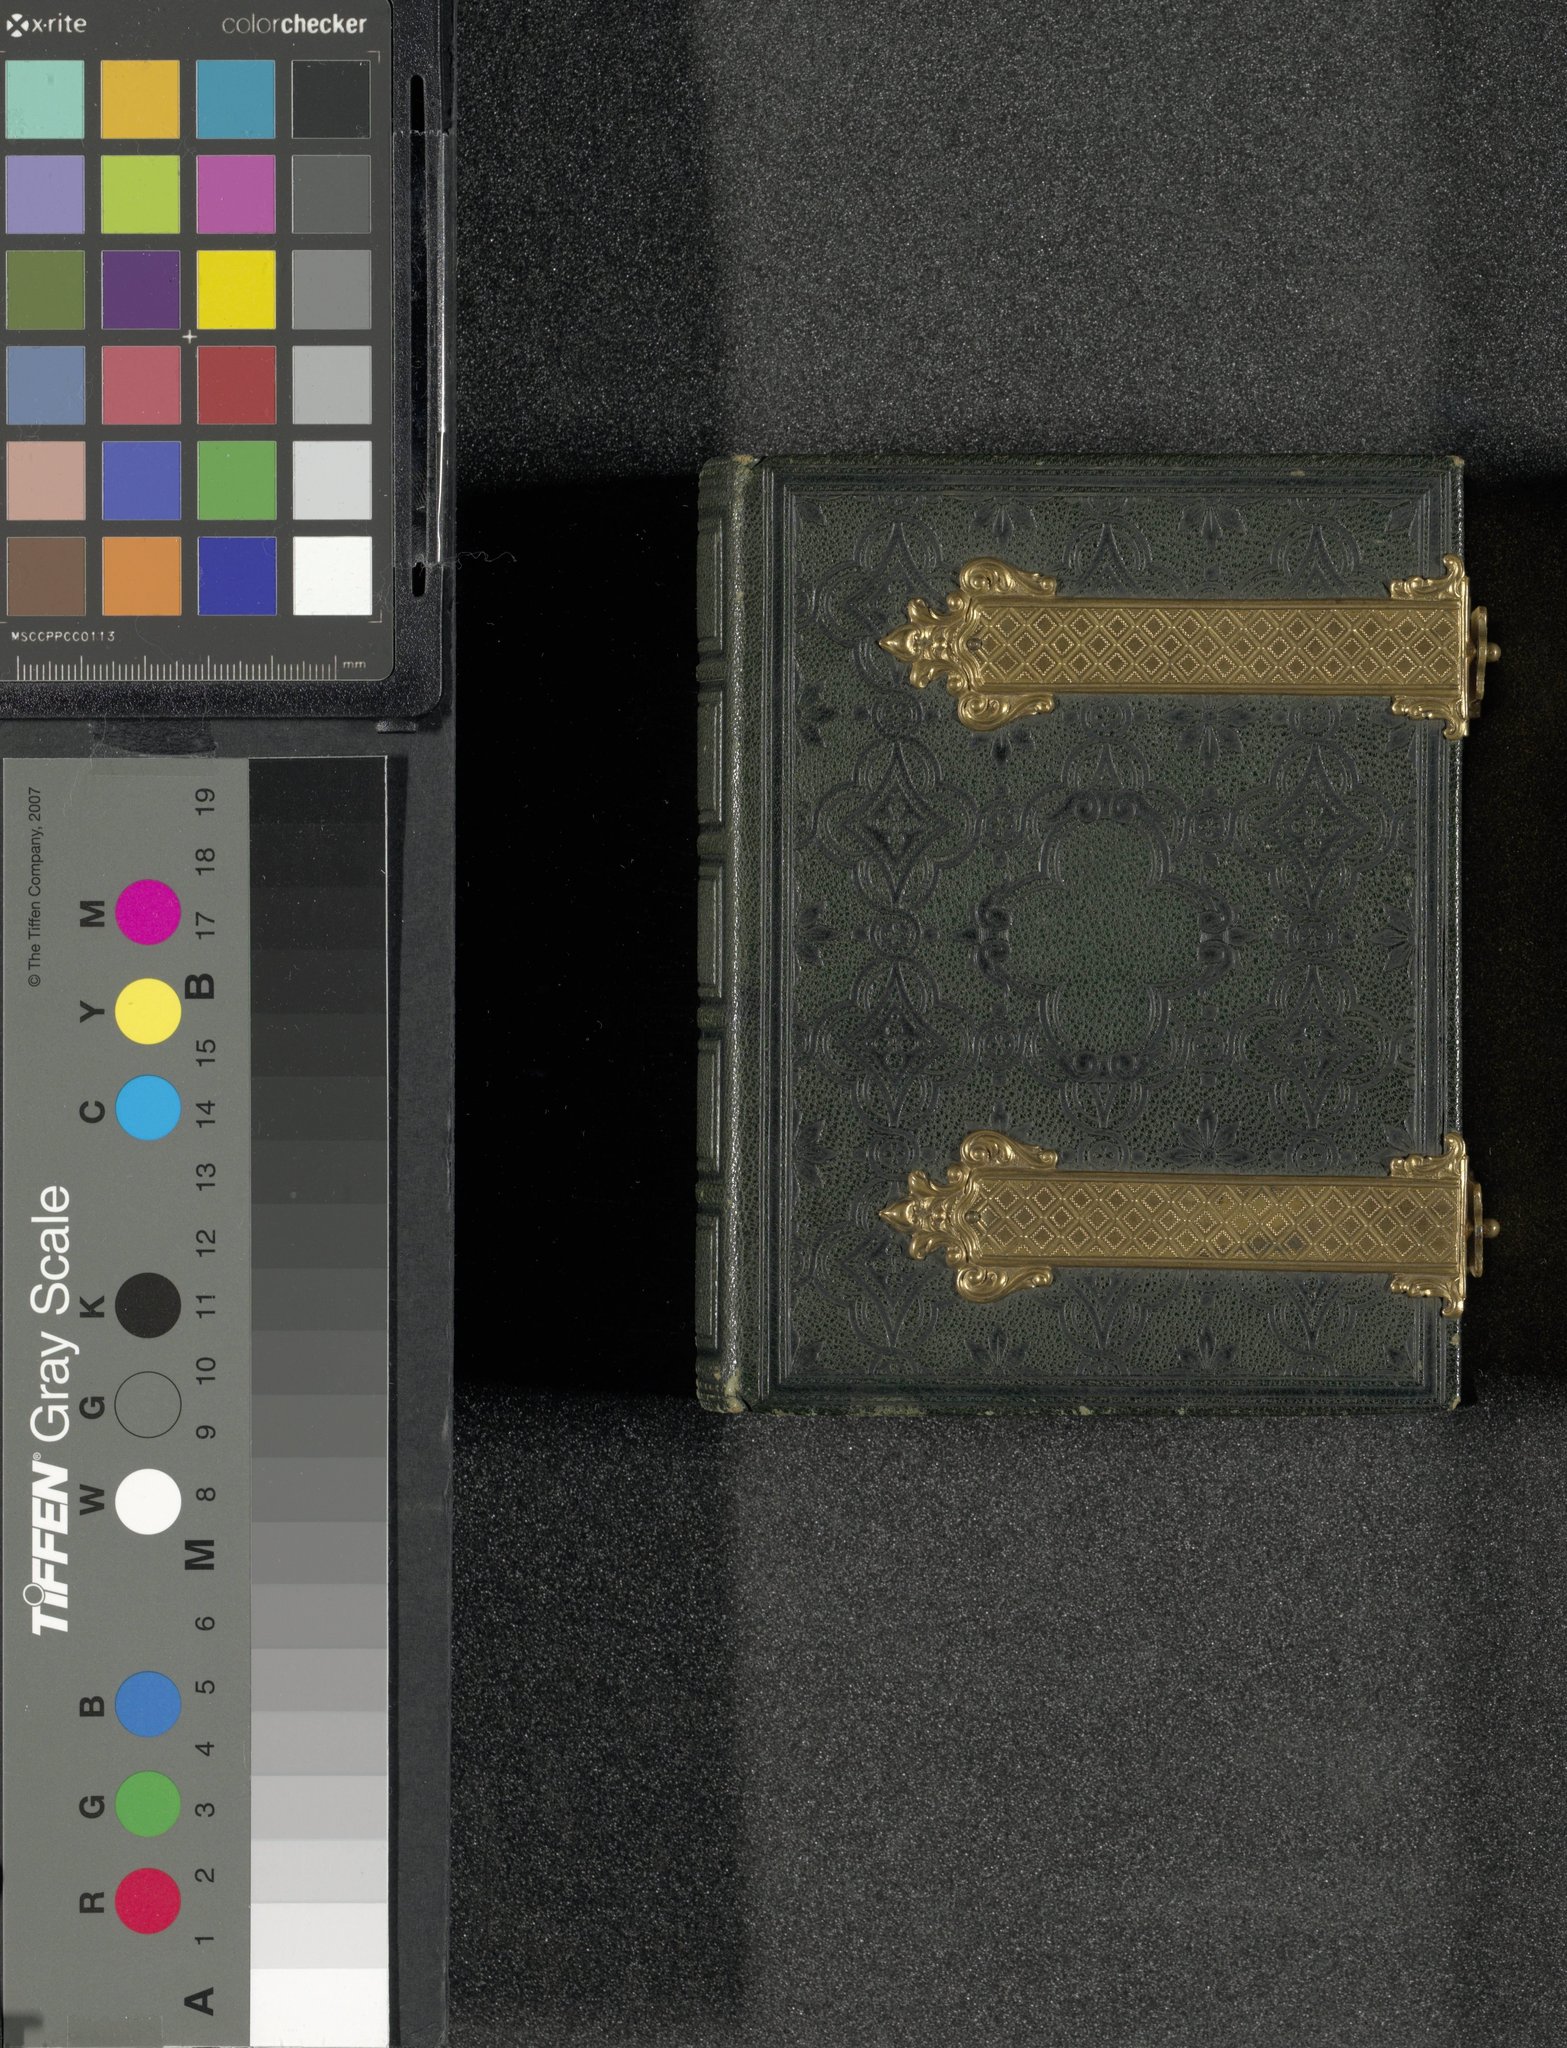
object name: photograph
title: Fotoalbum met 29 foto's van Nederlandse vorsten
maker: Anonymous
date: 1860-1890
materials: brass, cardboard, leather, paper, photographic support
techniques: albumen print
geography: europe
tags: historical persons, ruler, sovereign - bb - female ruler, ruler, sovereign, stadtholder, netherlands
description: Fotoalbum in groen omslag met geometrische en plantenmotieven in reliëf. De voor-en achterzijde zijn voorzien van koperkleurig versierd beslag. Aan de zijkant twee sloten. De schutbladen zijn van changeantpapier. Het album bevat 15 insteekbladen met goud op snee. Daarin 29 foto's op het formaat van cartes-de-visite in passe-partouts. Elk passe-partout heeft een kader in gouddruk. Het betreft opnames, vaak naar een prent, van leden van het Nederlandse vorstenhuis. In een hoesje is bijgevoegd een handgeschreven lijst met namen en functies van de afgebeelde personen, aangevuld met jaartallen.